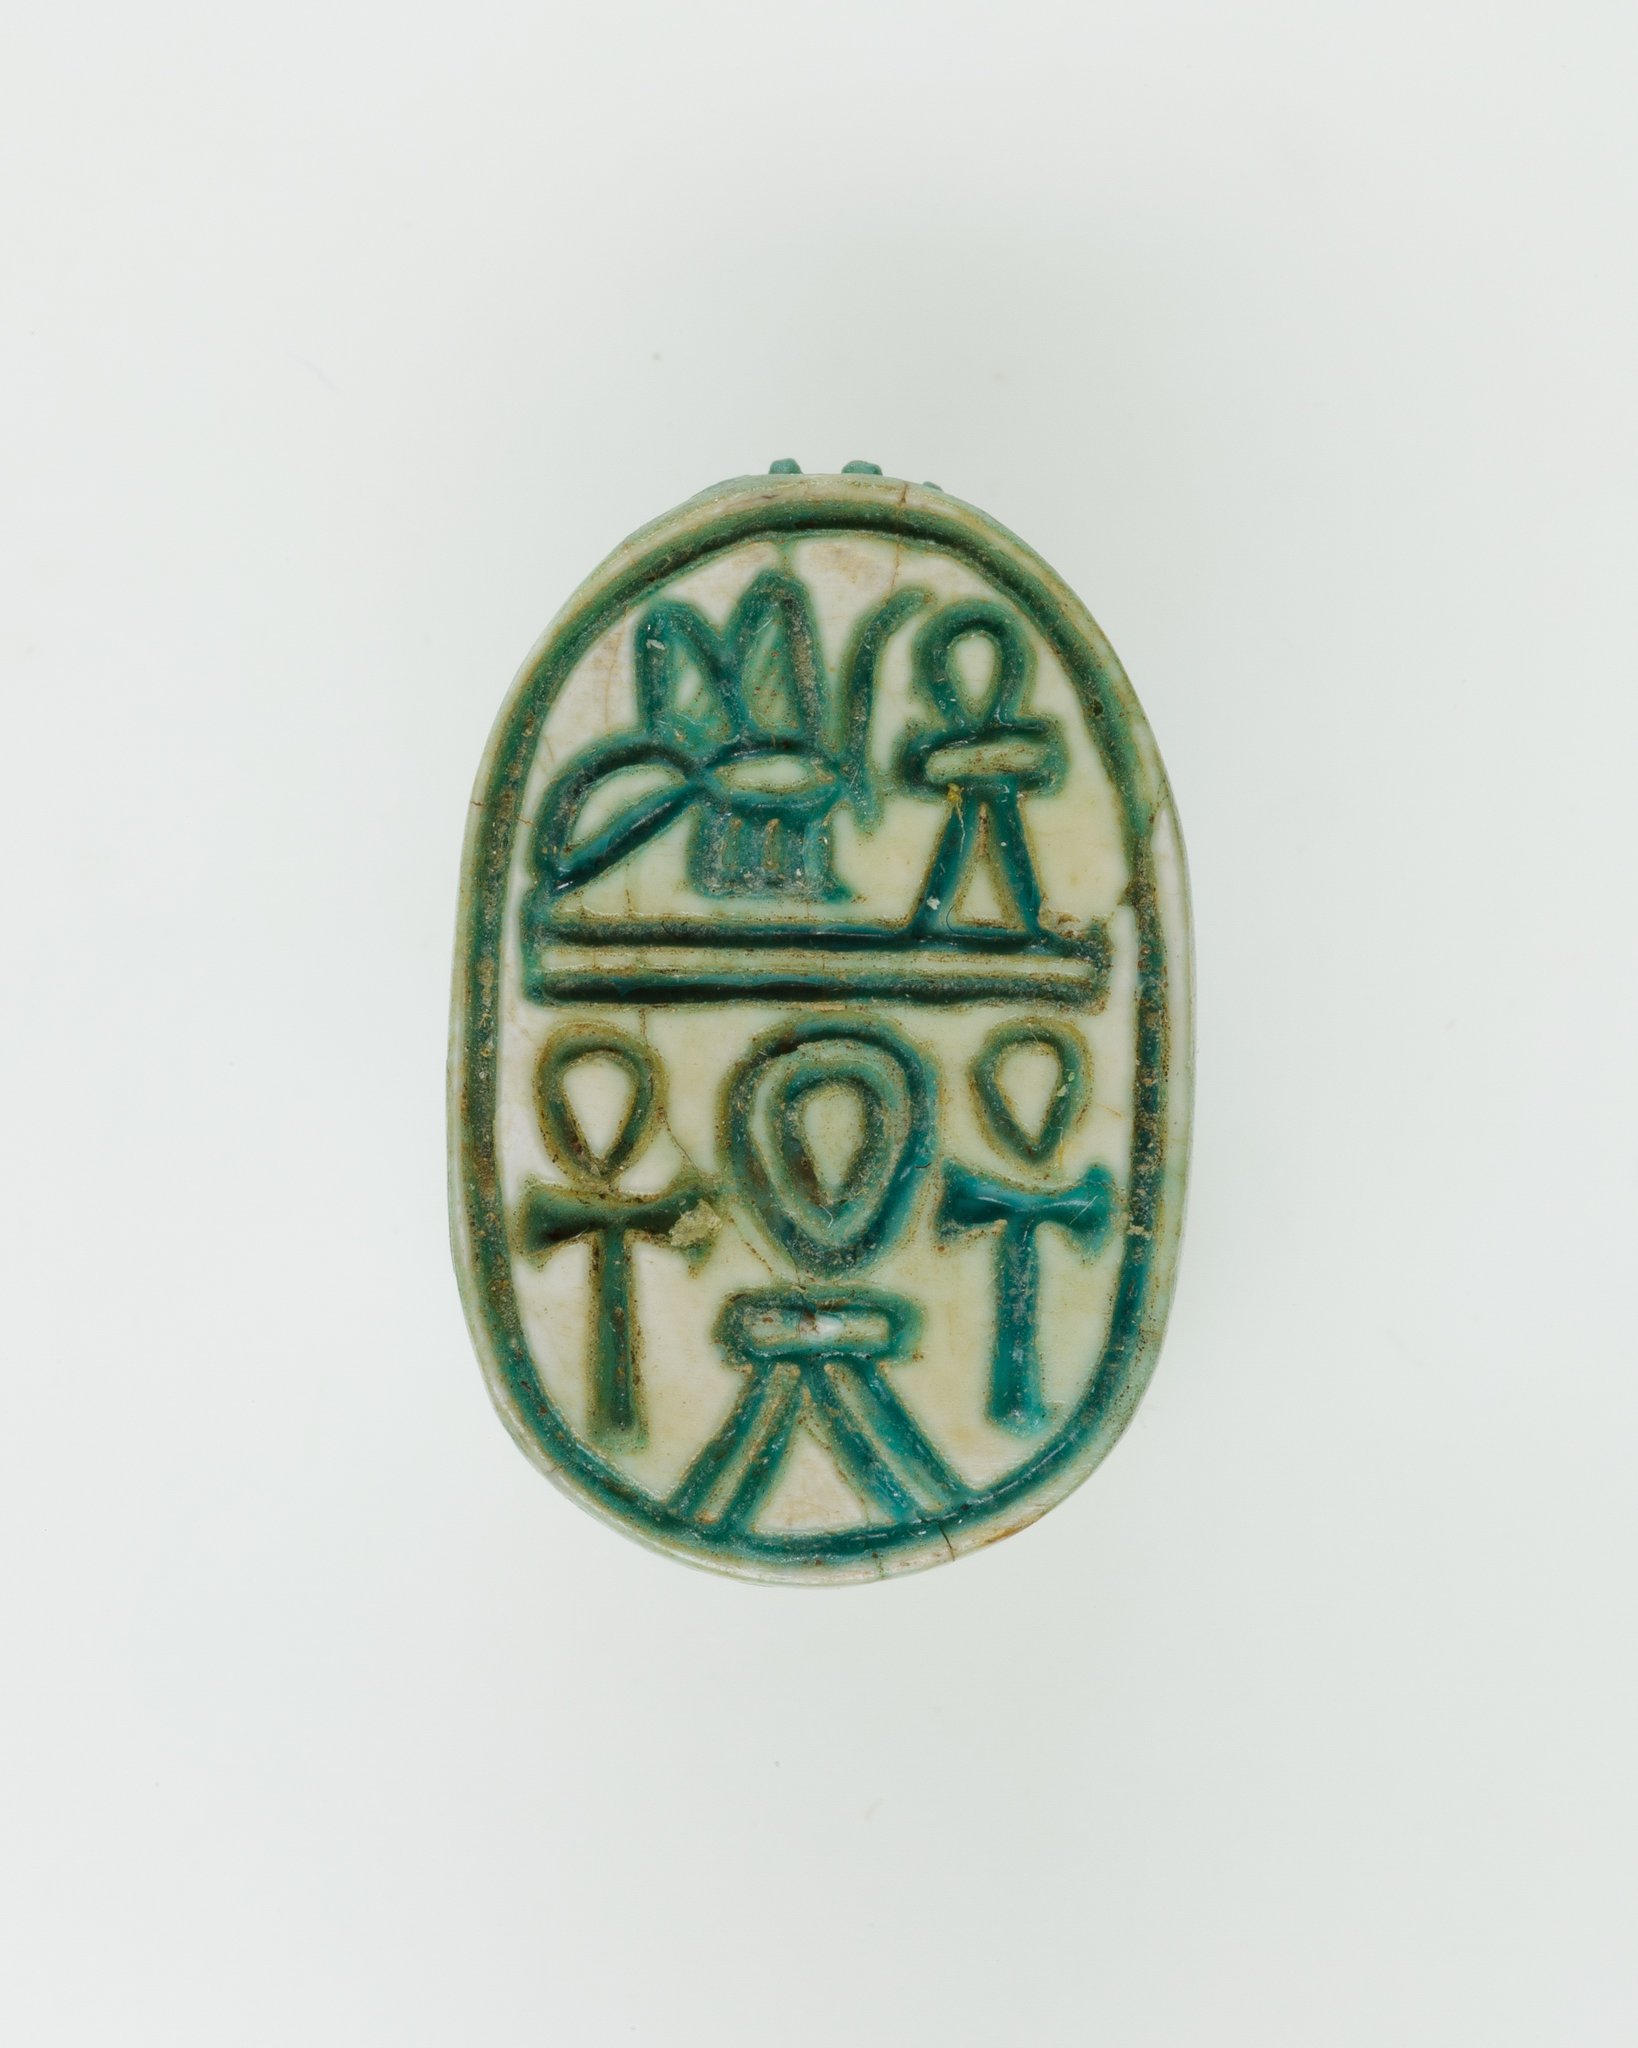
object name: scarab, hieroglyph, bee, ankh, sa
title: Scarab Inscribed with Hieroglyphs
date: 1850-1640 BCE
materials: stone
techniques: glazing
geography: egypt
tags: hieroglyphs,scarabs